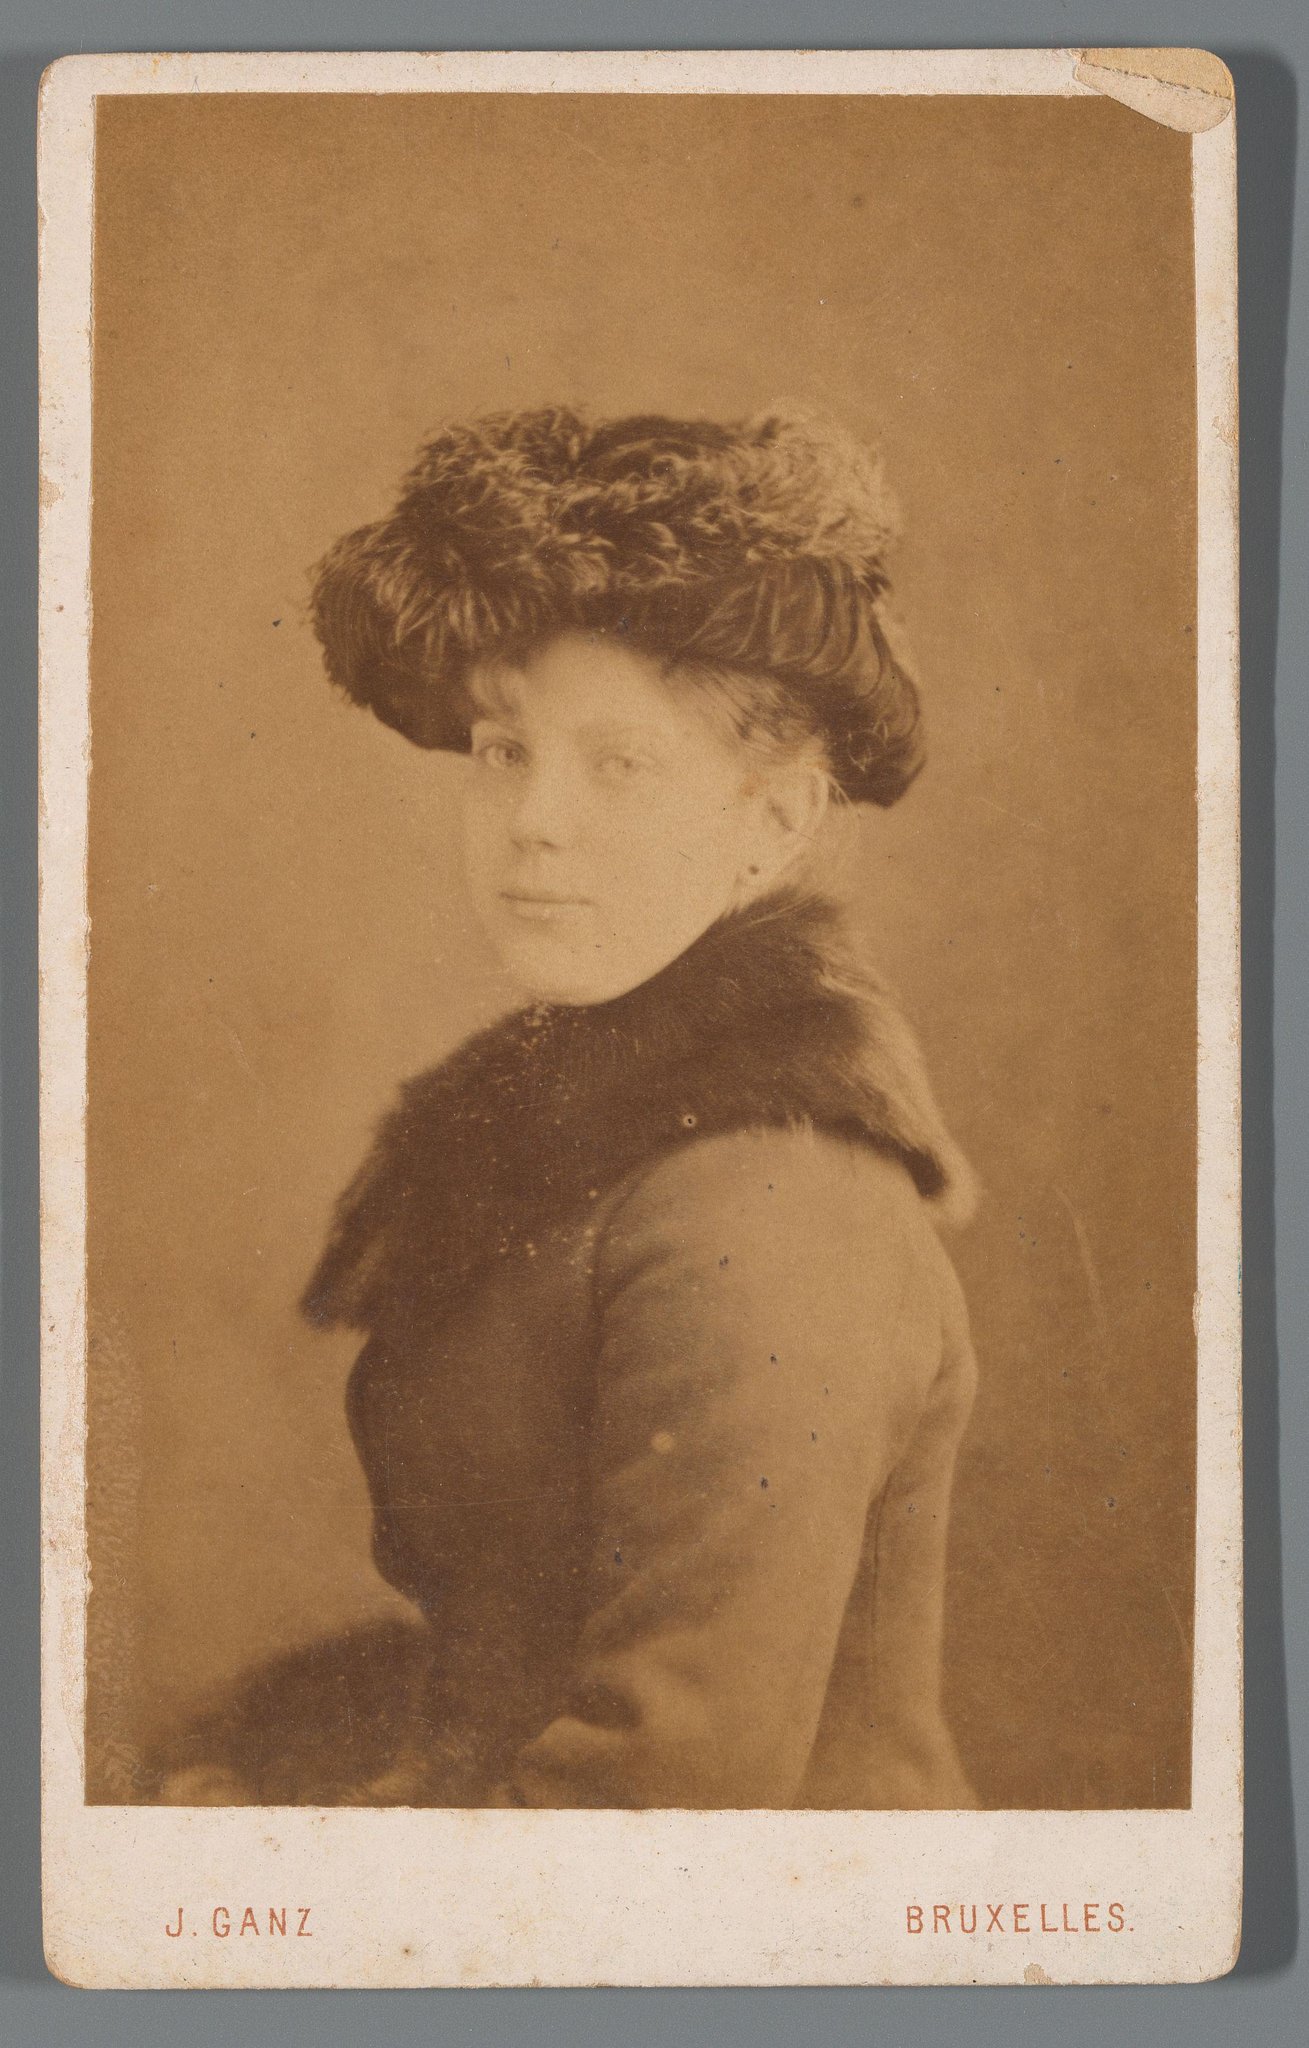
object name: carte de visite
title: Studioportret van Pauline van den Berg met hoed met struisvogelveren en een bontkraag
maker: j. ganz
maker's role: fotograaf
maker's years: 1872-1954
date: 1880-1910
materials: cardboard, photographic support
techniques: albumen print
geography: brussels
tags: batavia, the hague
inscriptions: name: ‘J. Ganz / 38, Rue de l'Ecuyer / en face des Galeries St. Hubert . / BRUXELLES / MÊME MAISON À ZÜRICH’, inscription: ‘J. GANZ / BRUXELLES.’, inscription: ‘Pau van den Berg’